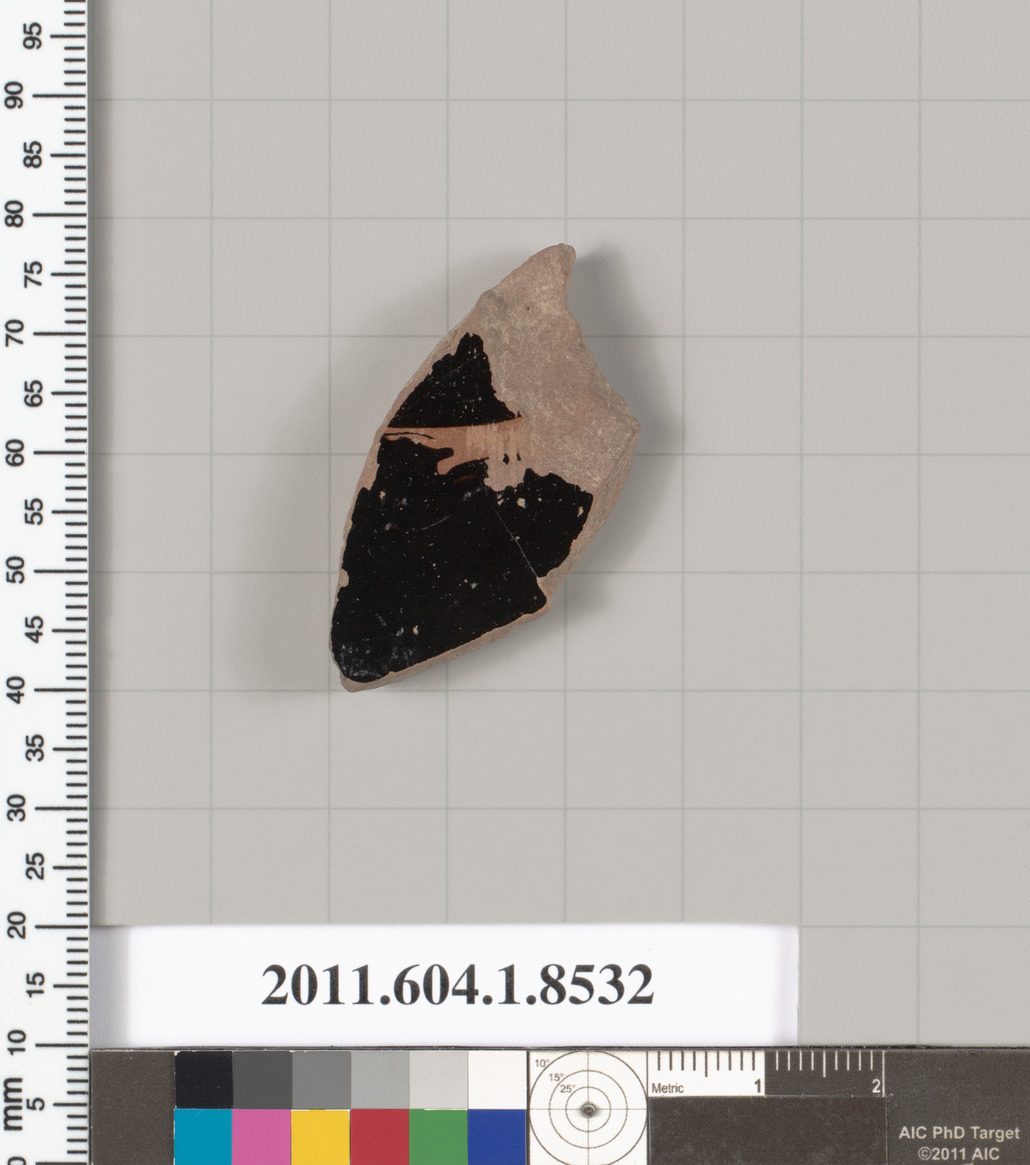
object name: kylix fragment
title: Terracotta fragment of a stemless kylix (drinking cup)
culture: greek, attic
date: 467-435 BCE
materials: terracotta